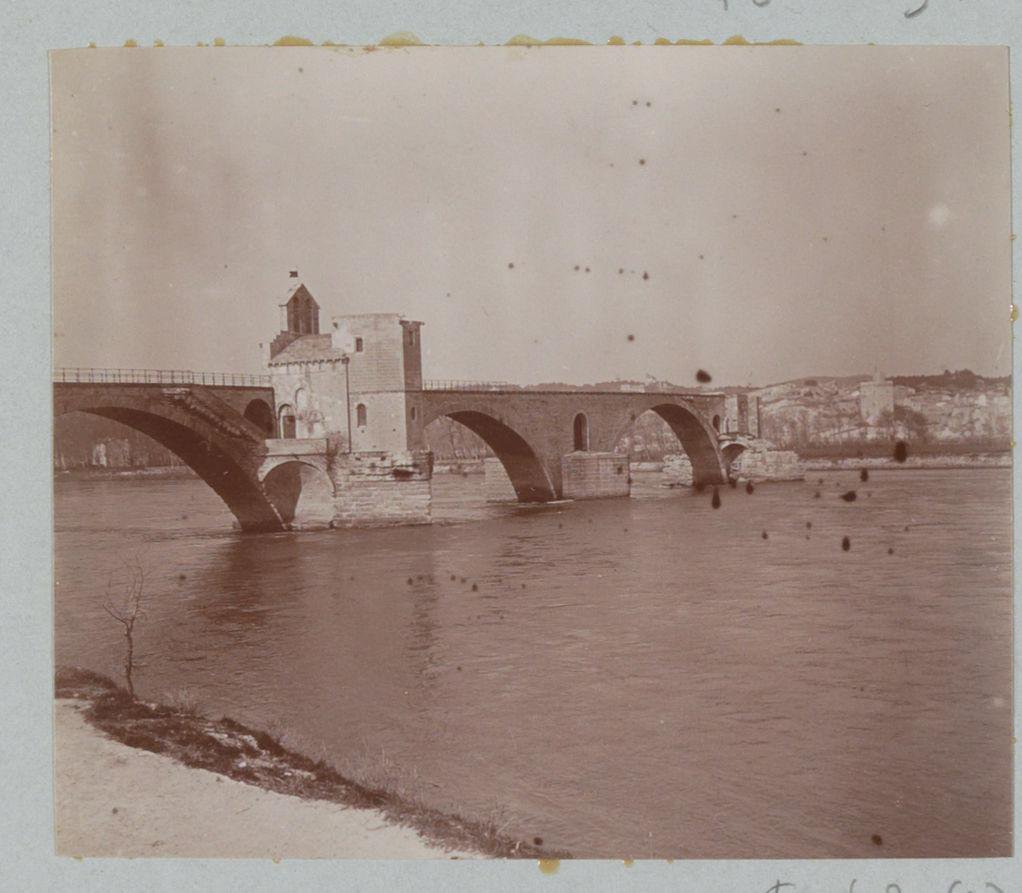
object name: photograph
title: Gezicht op de brug van Avignon (Pont Saint-Bénézet)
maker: Anonymous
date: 1905-1910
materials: paper, photographic support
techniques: gelatin silver print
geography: avignon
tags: bridge, prospect of city, town panorama, silhouette of city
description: Onderdeel van Fotoalbum van een Franse amateurfotograaf met bezienswaardigheden in Frankrijk, Zwitserland en Italië.